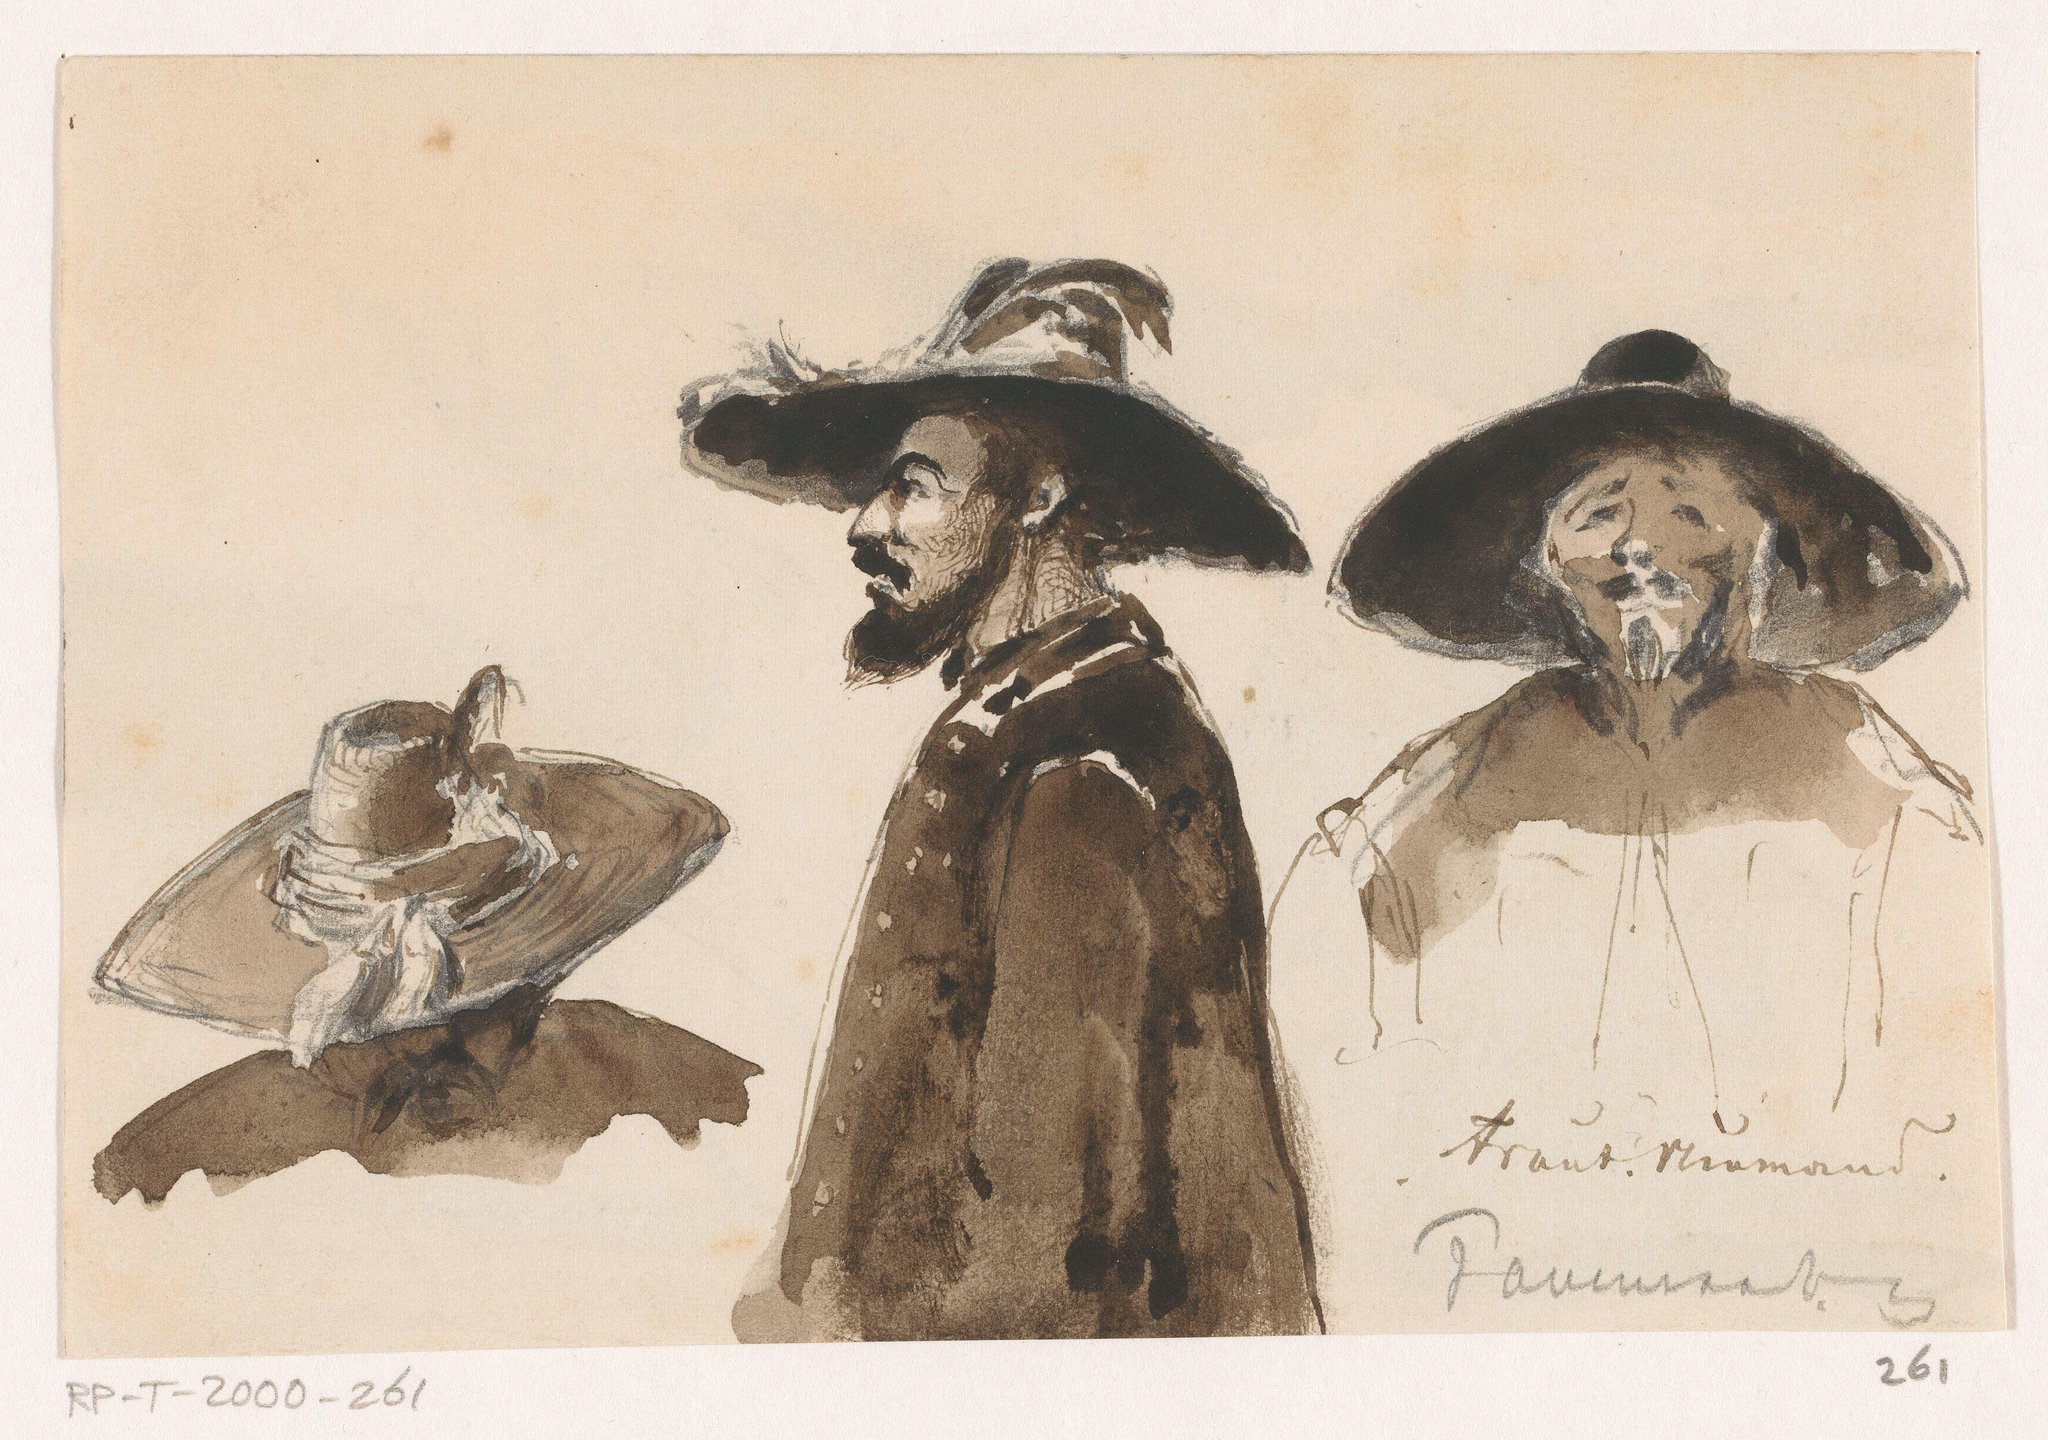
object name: drawing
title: Studies van een man met brede hoed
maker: johannes tavenraat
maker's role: draughtsman, painter, print maker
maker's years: 1809-1881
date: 1840-1880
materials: ink, paper, pencil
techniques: brush, pen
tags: historical persons, head-gear: hat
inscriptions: signature: ‘Tavenraat’, annotation: ‘Arant ... umans’